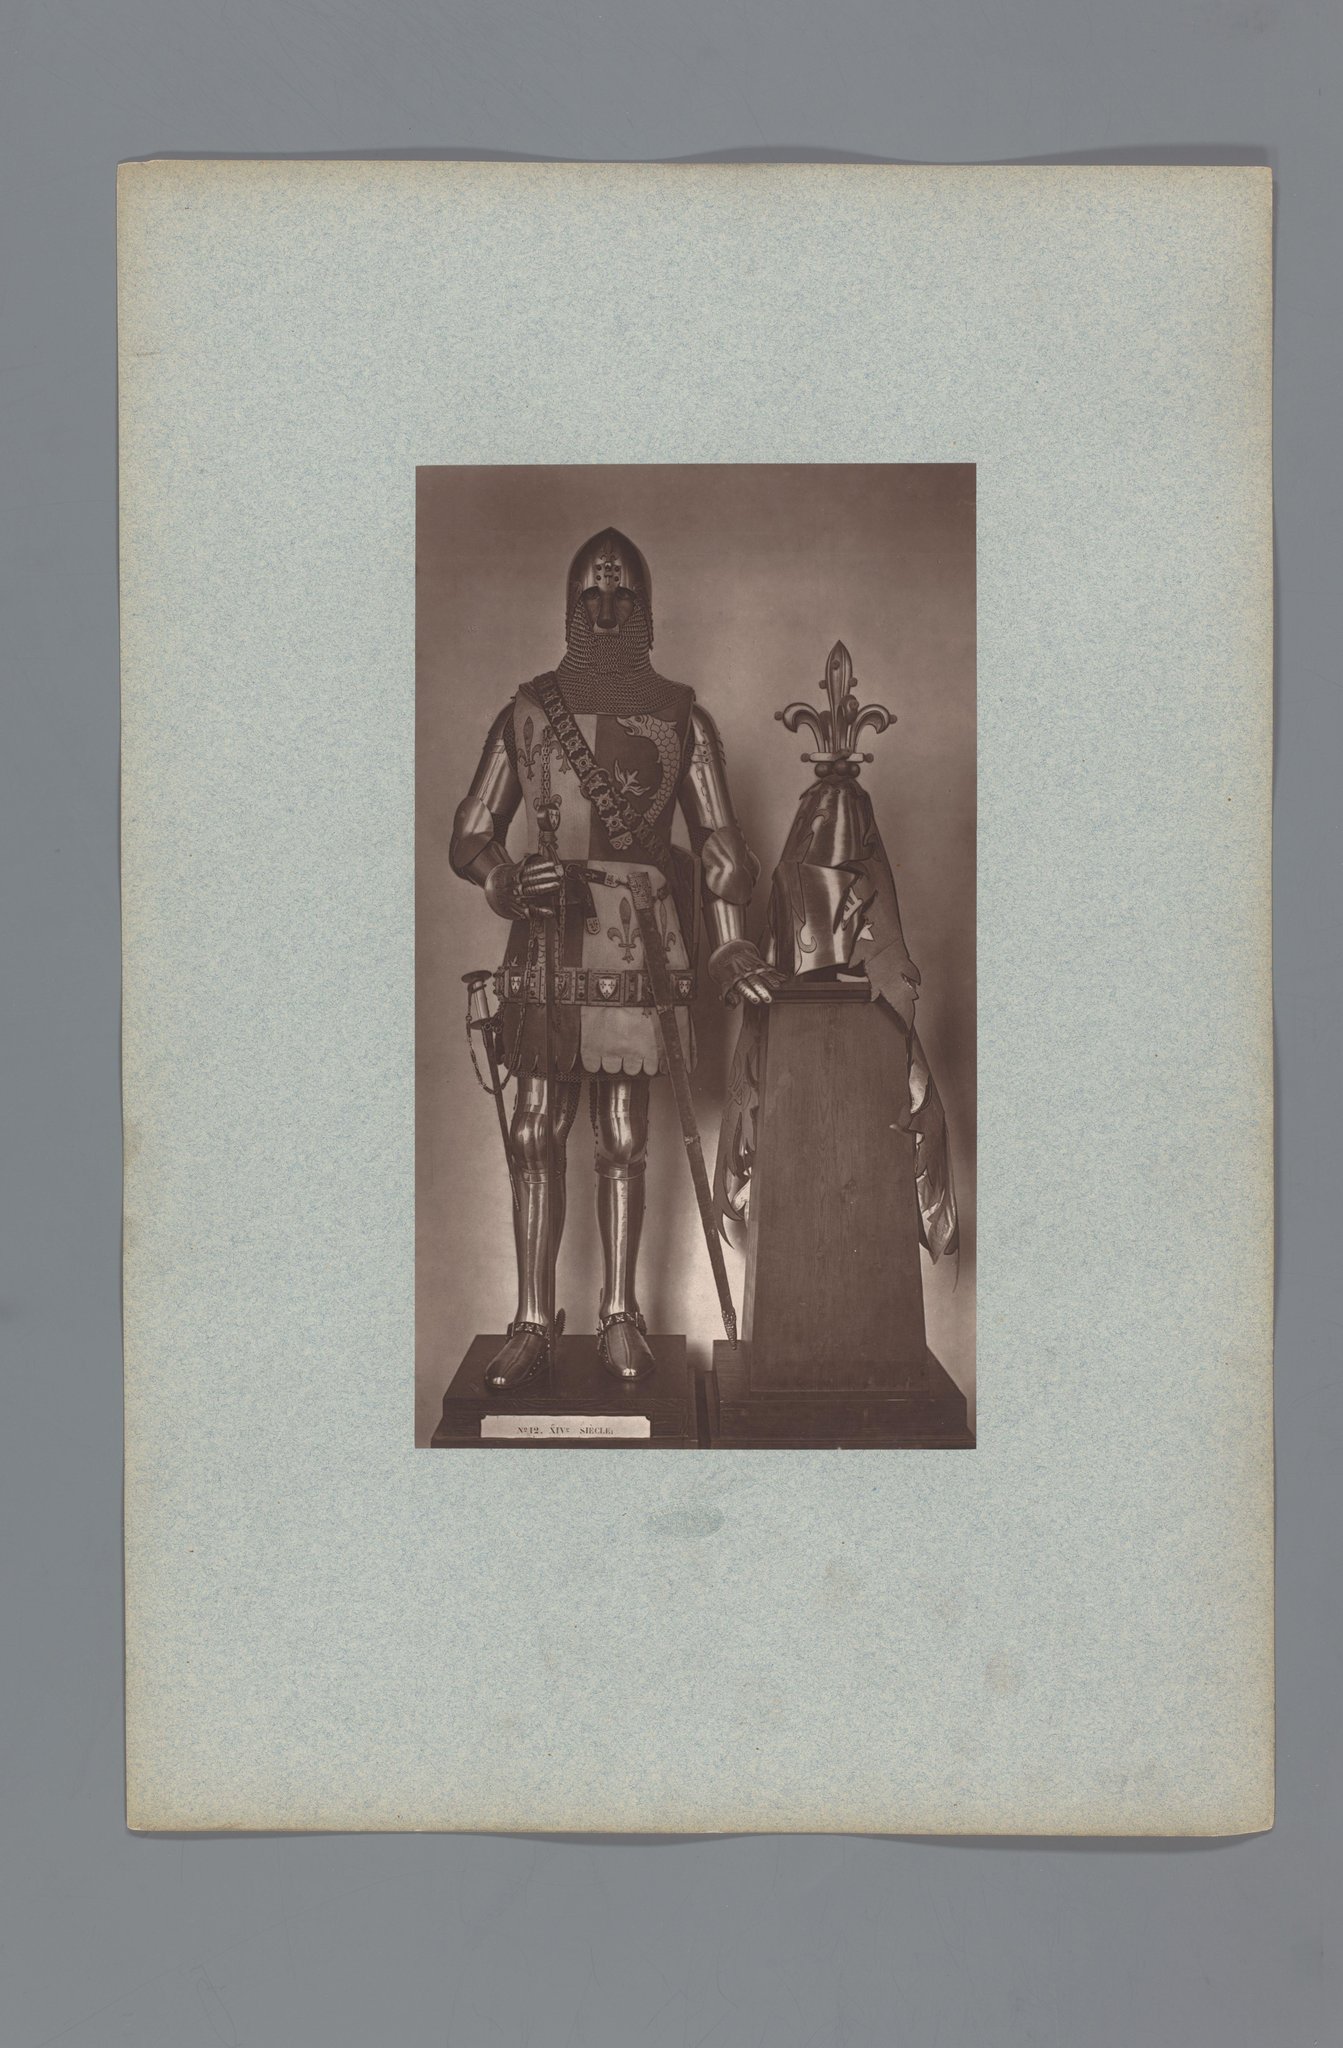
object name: photomechanical print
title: 14de-eeuws harnas uit het leger van Jan II van Frankrijk, uit de collectie van het Musée d'Artillerie in Parijs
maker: Anonymous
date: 1877-1882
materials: paper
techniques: woodburytype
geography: paris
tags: armour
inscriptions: check stamp: ‘PHOTOGLYPTIE/ LEMERCIER ET Cie/ PARIS’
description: Deze prent maakt deel uit van een omslag met 36 prenten, een titelblad en een lijst van afbeeldingen.